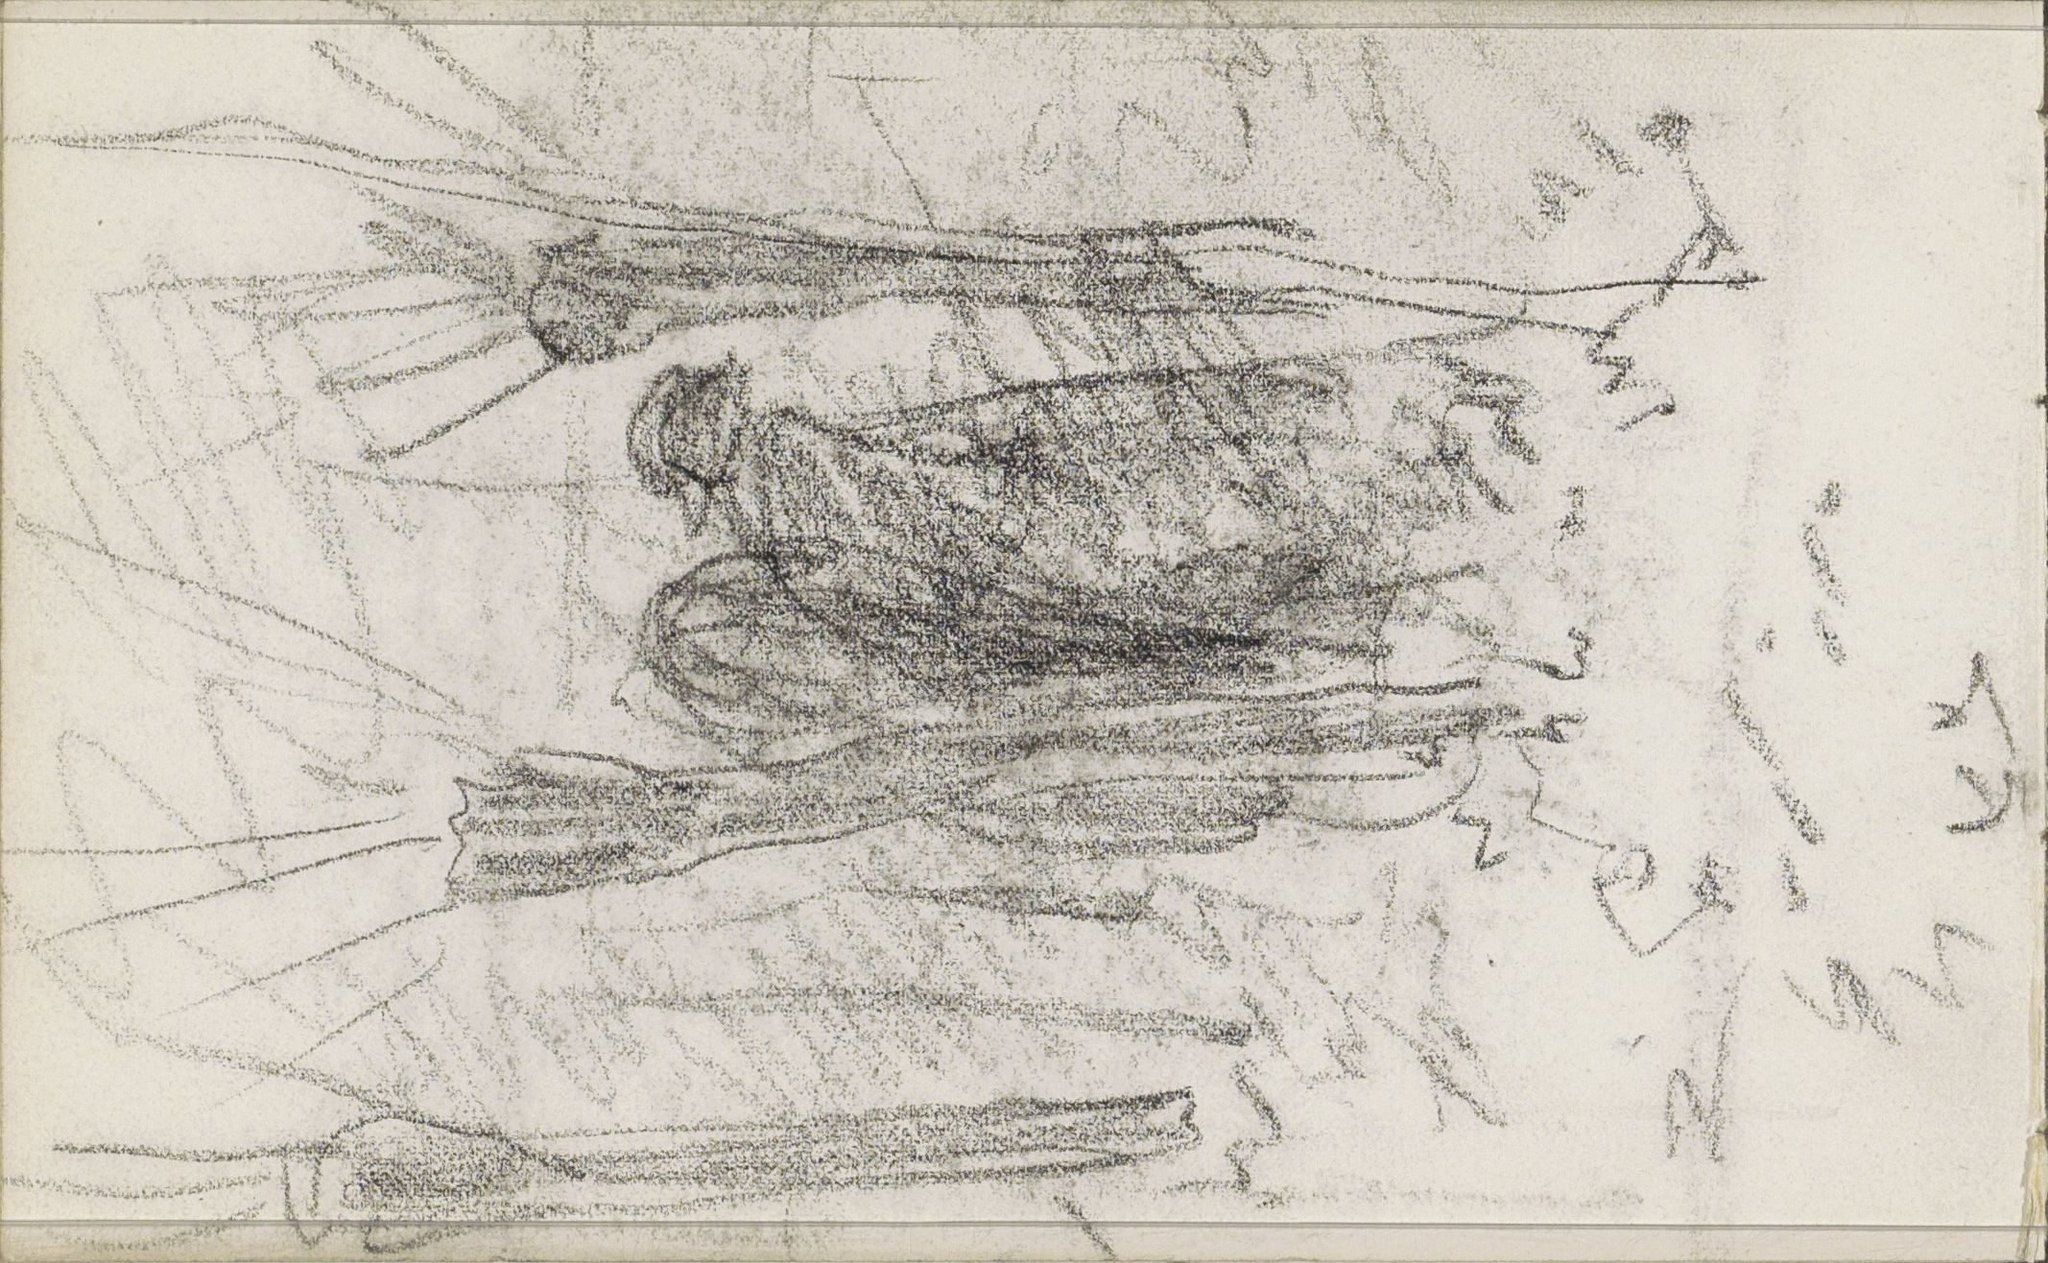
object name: sketchbook leaf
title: Knotwilgen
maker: anton mauve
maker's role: draughtsman, painter, print maker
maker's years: 1838-1888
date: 1848-1888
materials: chalk, paper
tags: trees: willow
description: Blad 12 verso uit een schetsboek met 43 bladen.